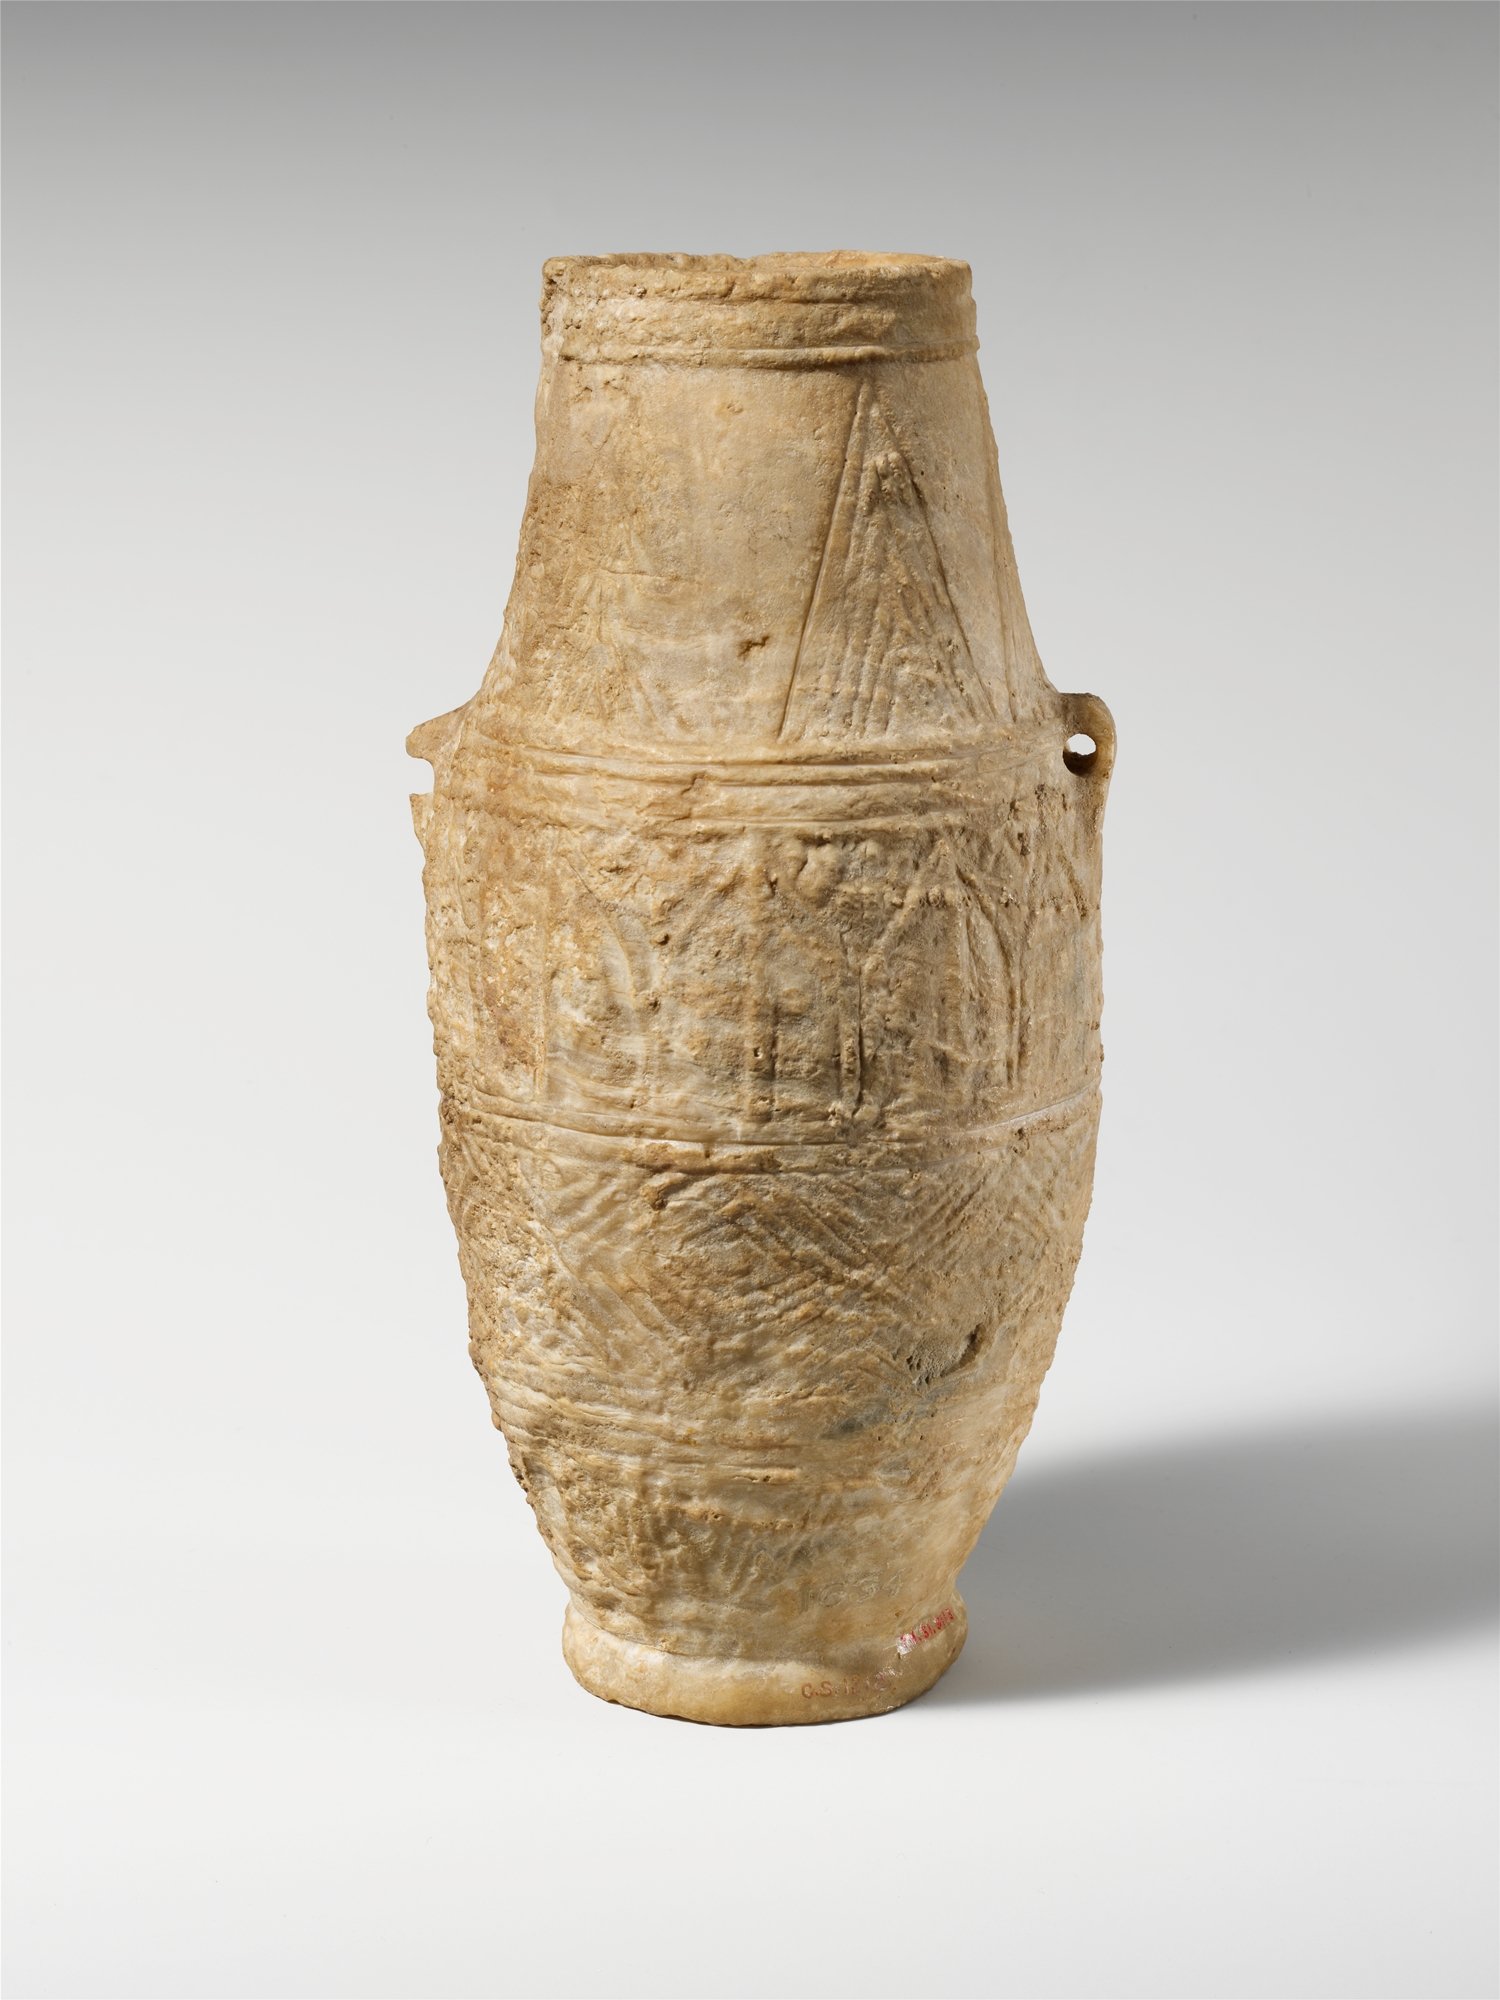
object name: jar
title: Gypsum jar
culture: cypriot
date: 1600-1050 BCE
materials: gypsum